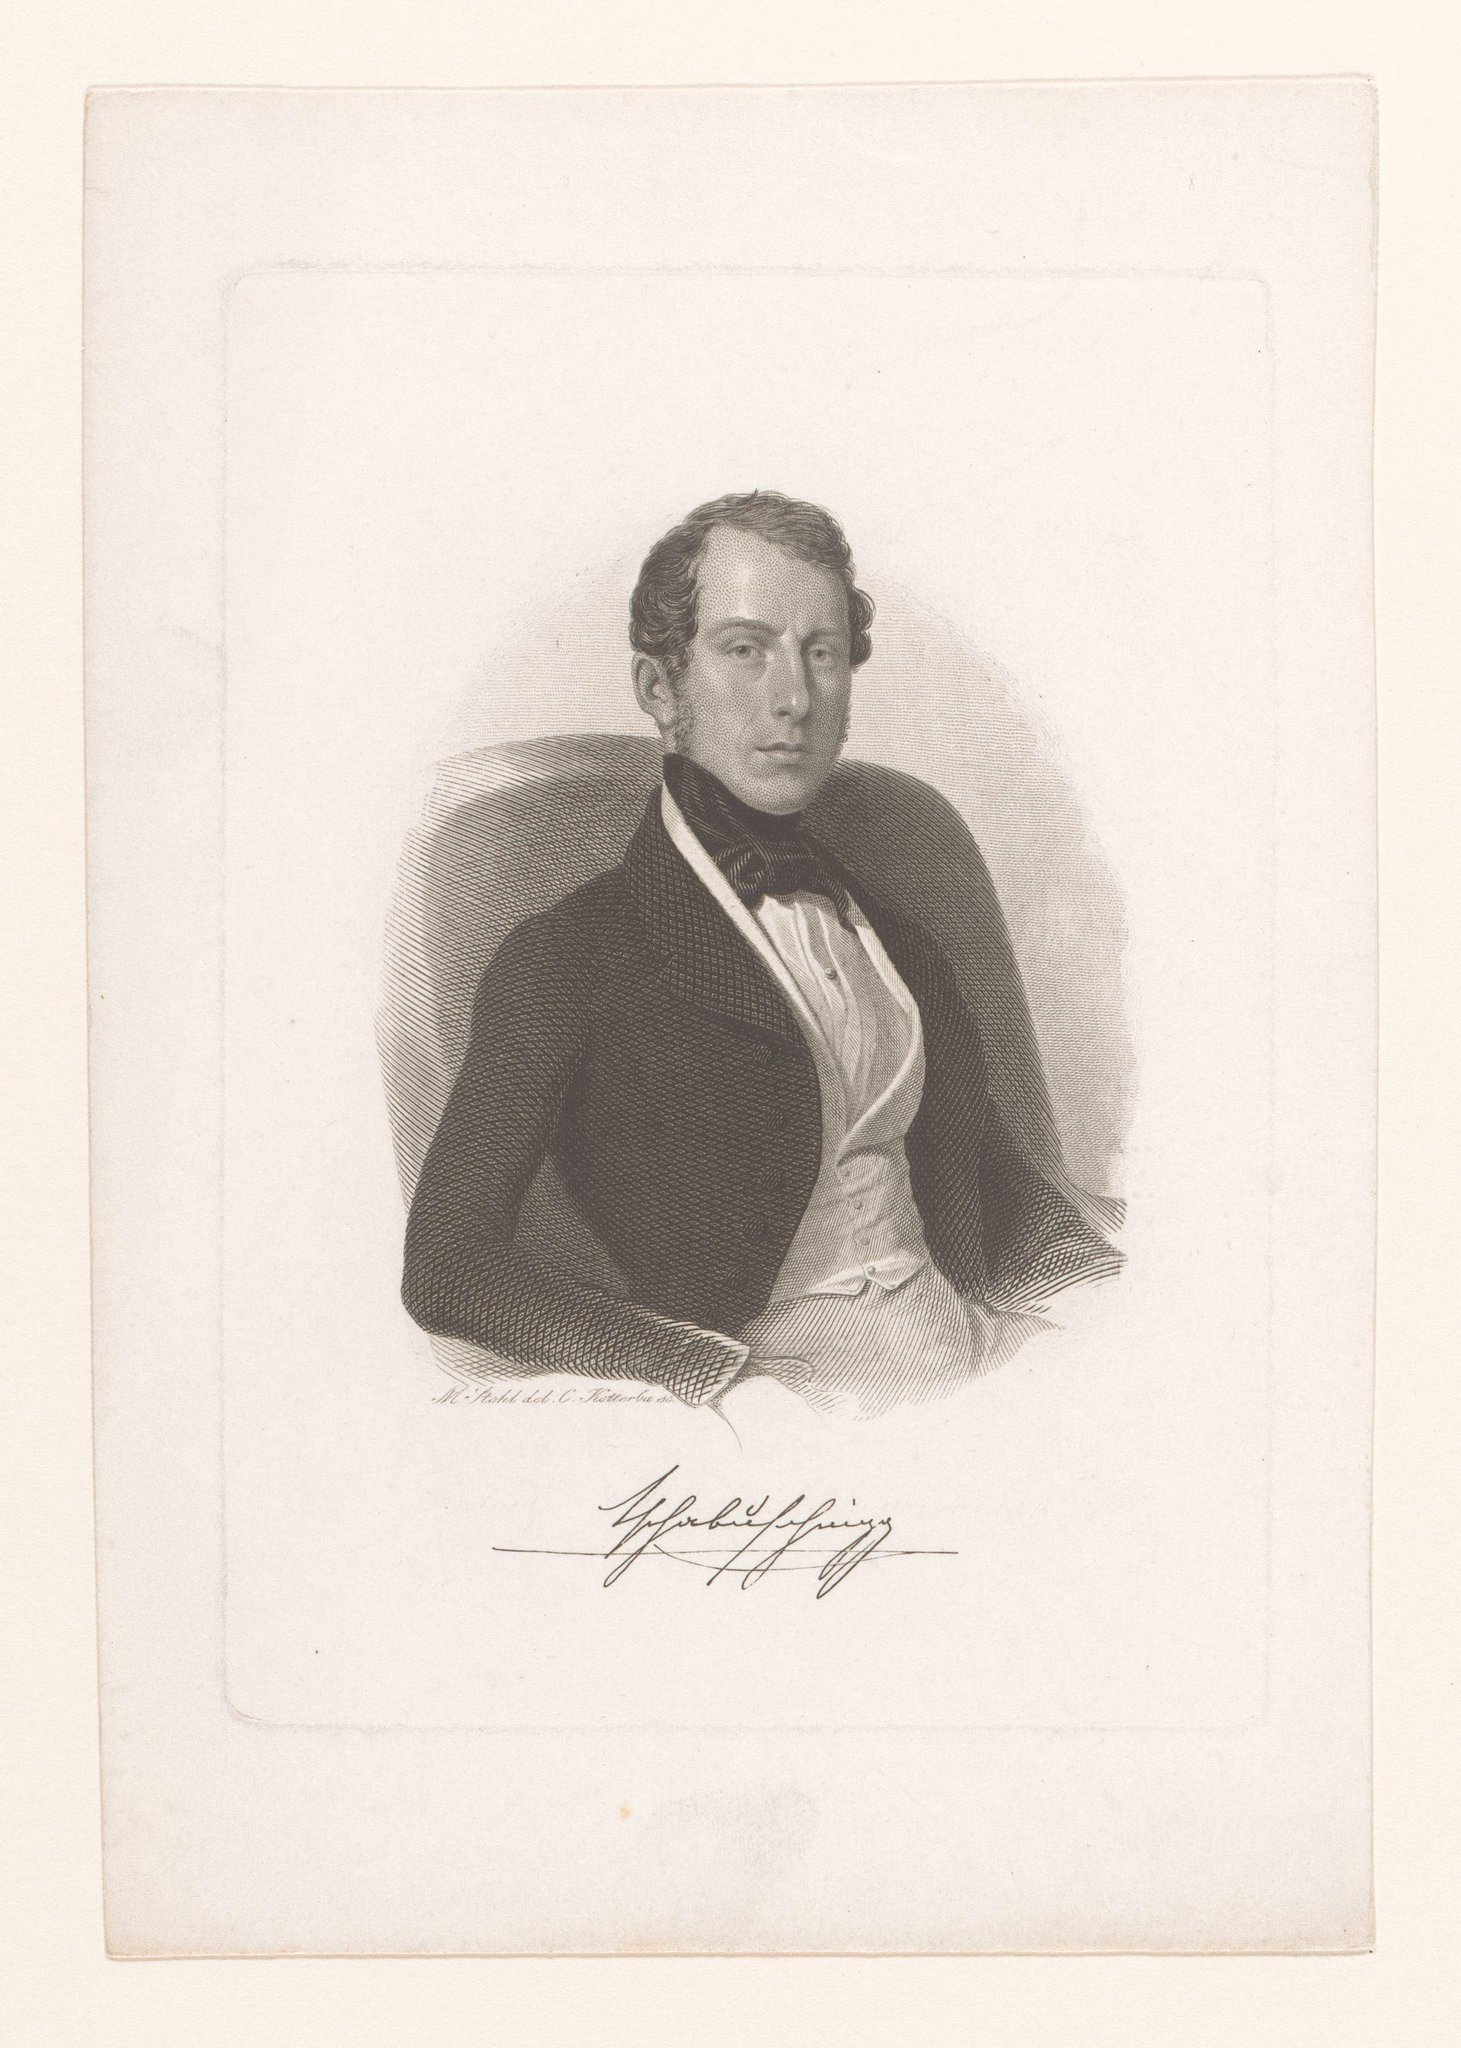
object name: print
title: Portret van Adolf von Tschabuschnigg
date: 1810-1859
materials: paper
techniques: engraving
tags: historical persons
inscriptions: collector's mark: Lugt 2228